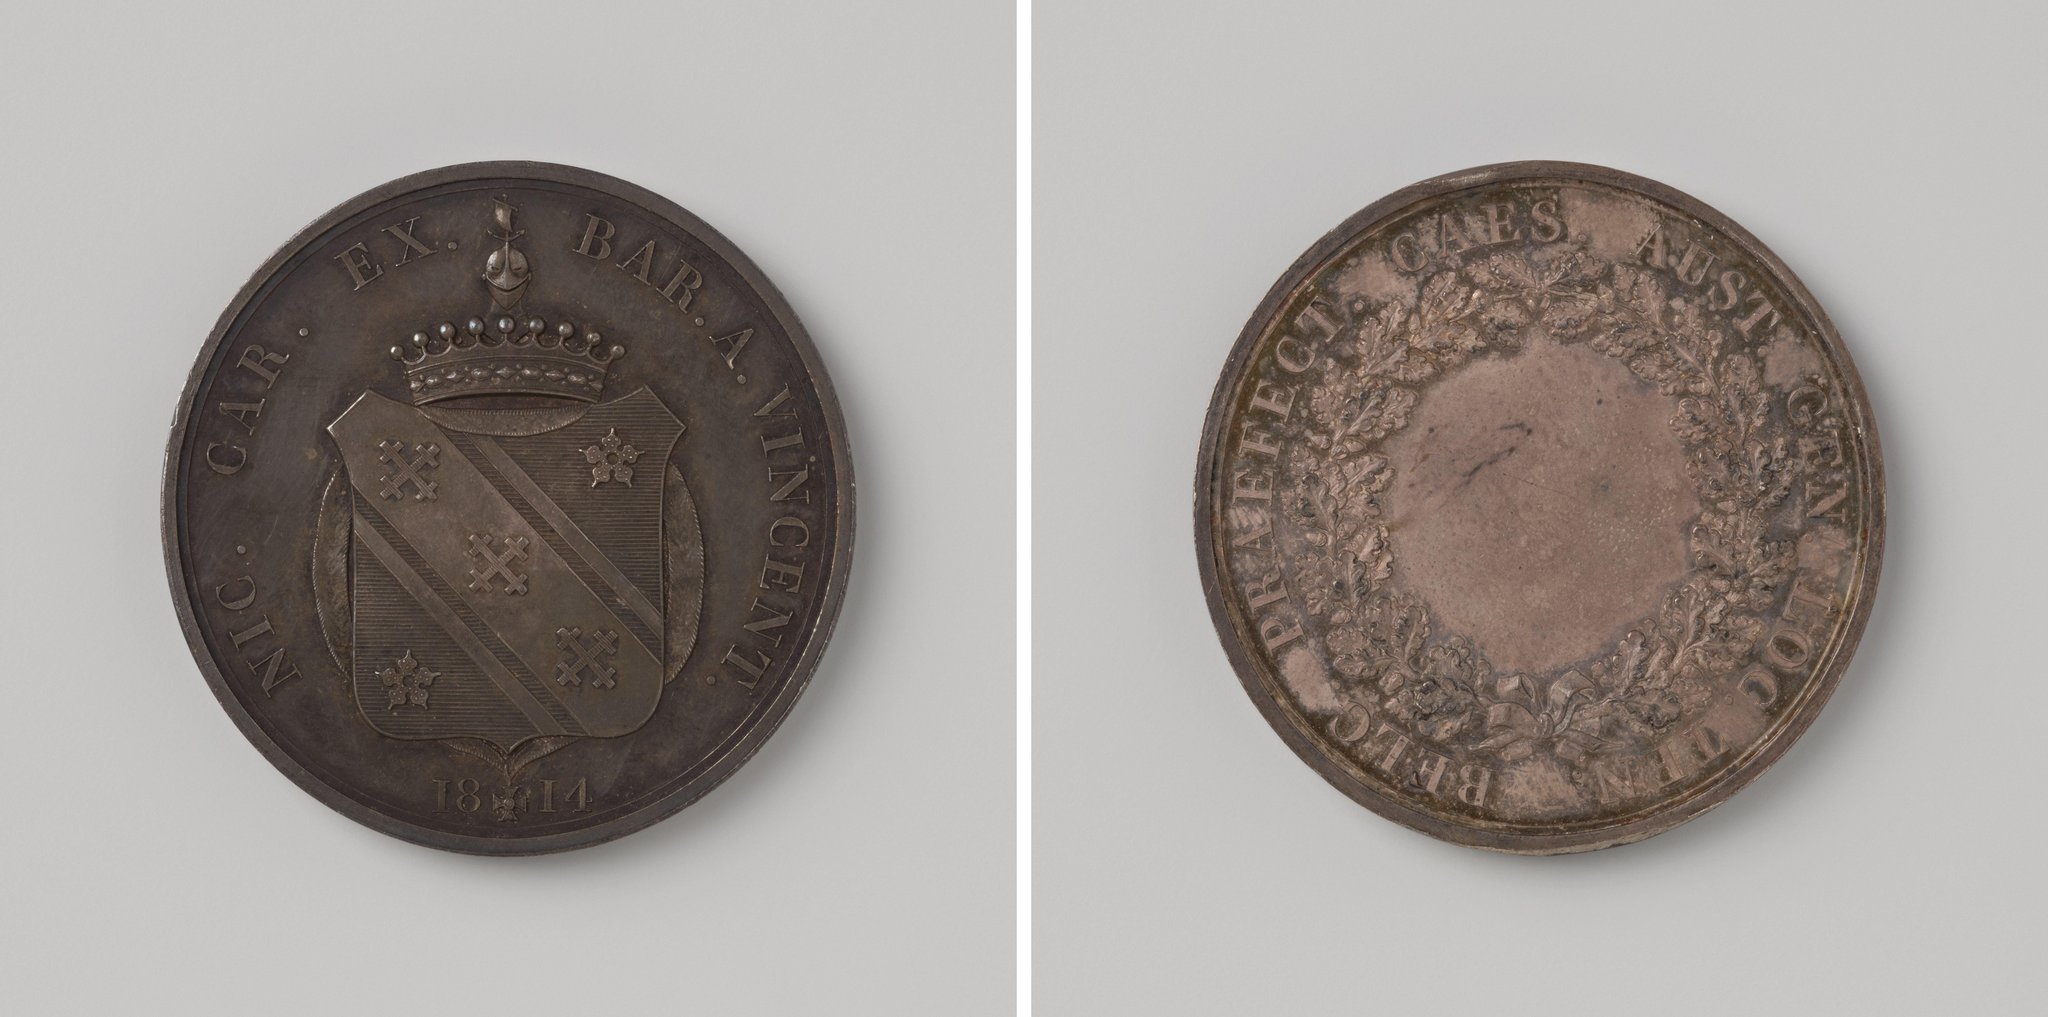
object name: history medal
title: Nicolaas Karel baron von Vincent, aangesteld als gouverneur der voormalige Oostenrijkse Nederlanden door keizer Frans I van Oostenrijk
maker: Anonymous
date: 1814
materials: bronze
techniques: striking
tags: vienna, frans ii (rooms-duits keizer), ghent, belgium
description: Bronzen penning. Voorzijde: gekroond wapenschild binnen omschrift. Keerzijde: blanco veld binnen eikekrans en omschrift